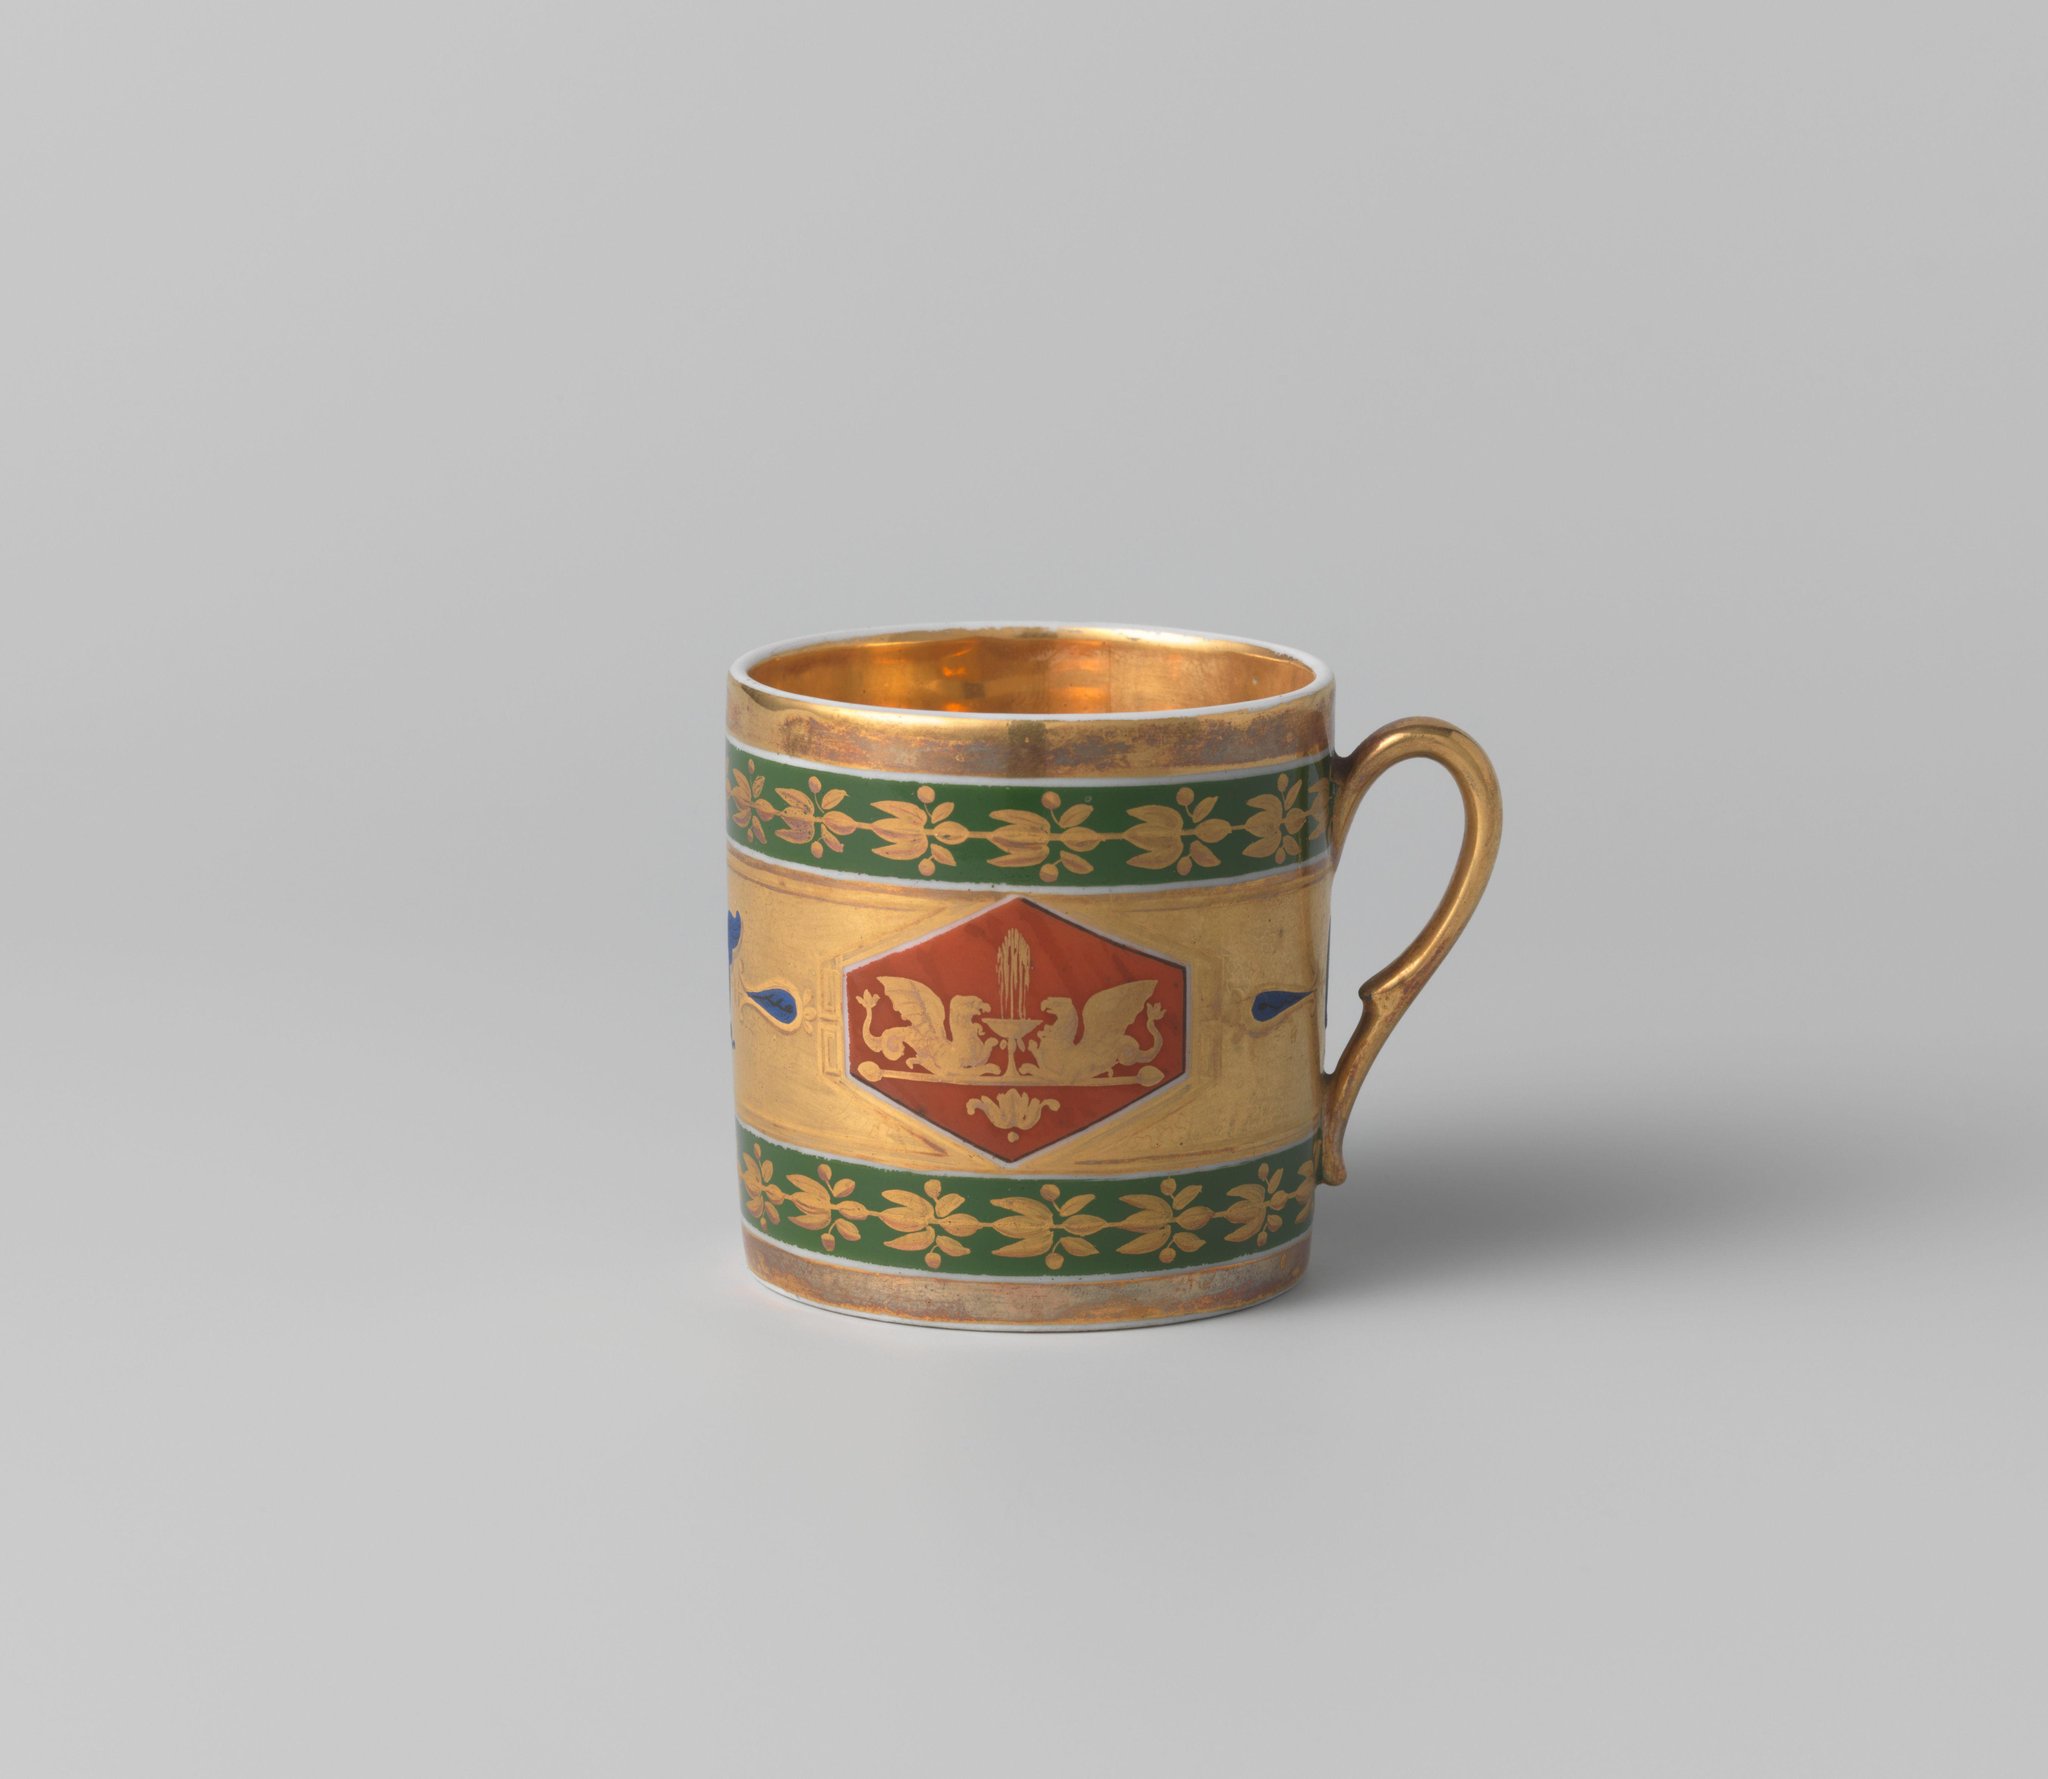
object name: cup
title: Cup with griffins and floral scrolls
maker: Anonymous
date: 1800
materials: glaze, gold, paint, porcelain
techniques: firing, forming, gilding, relief, turning, vitrification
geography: france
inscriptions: mark: ‘83’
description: Kop van porselein met een cilindrische wand en C-vormig oor, beschilderd op het glazuur in blauw, rood, groen, zwart en goud. Op de buitenwand een band met een kop die een gevleugelde helm draagt, geflankeerd door twee zeshoekige vakken met twee griffioenen bij een fontein. Onder en boven deze decoratie een band met bloemranken. Boven de voet en op de rand een gouden band. De binnenwand en het oor zijn bedekt met goud. Gemerkt op de onderzijde met 83.